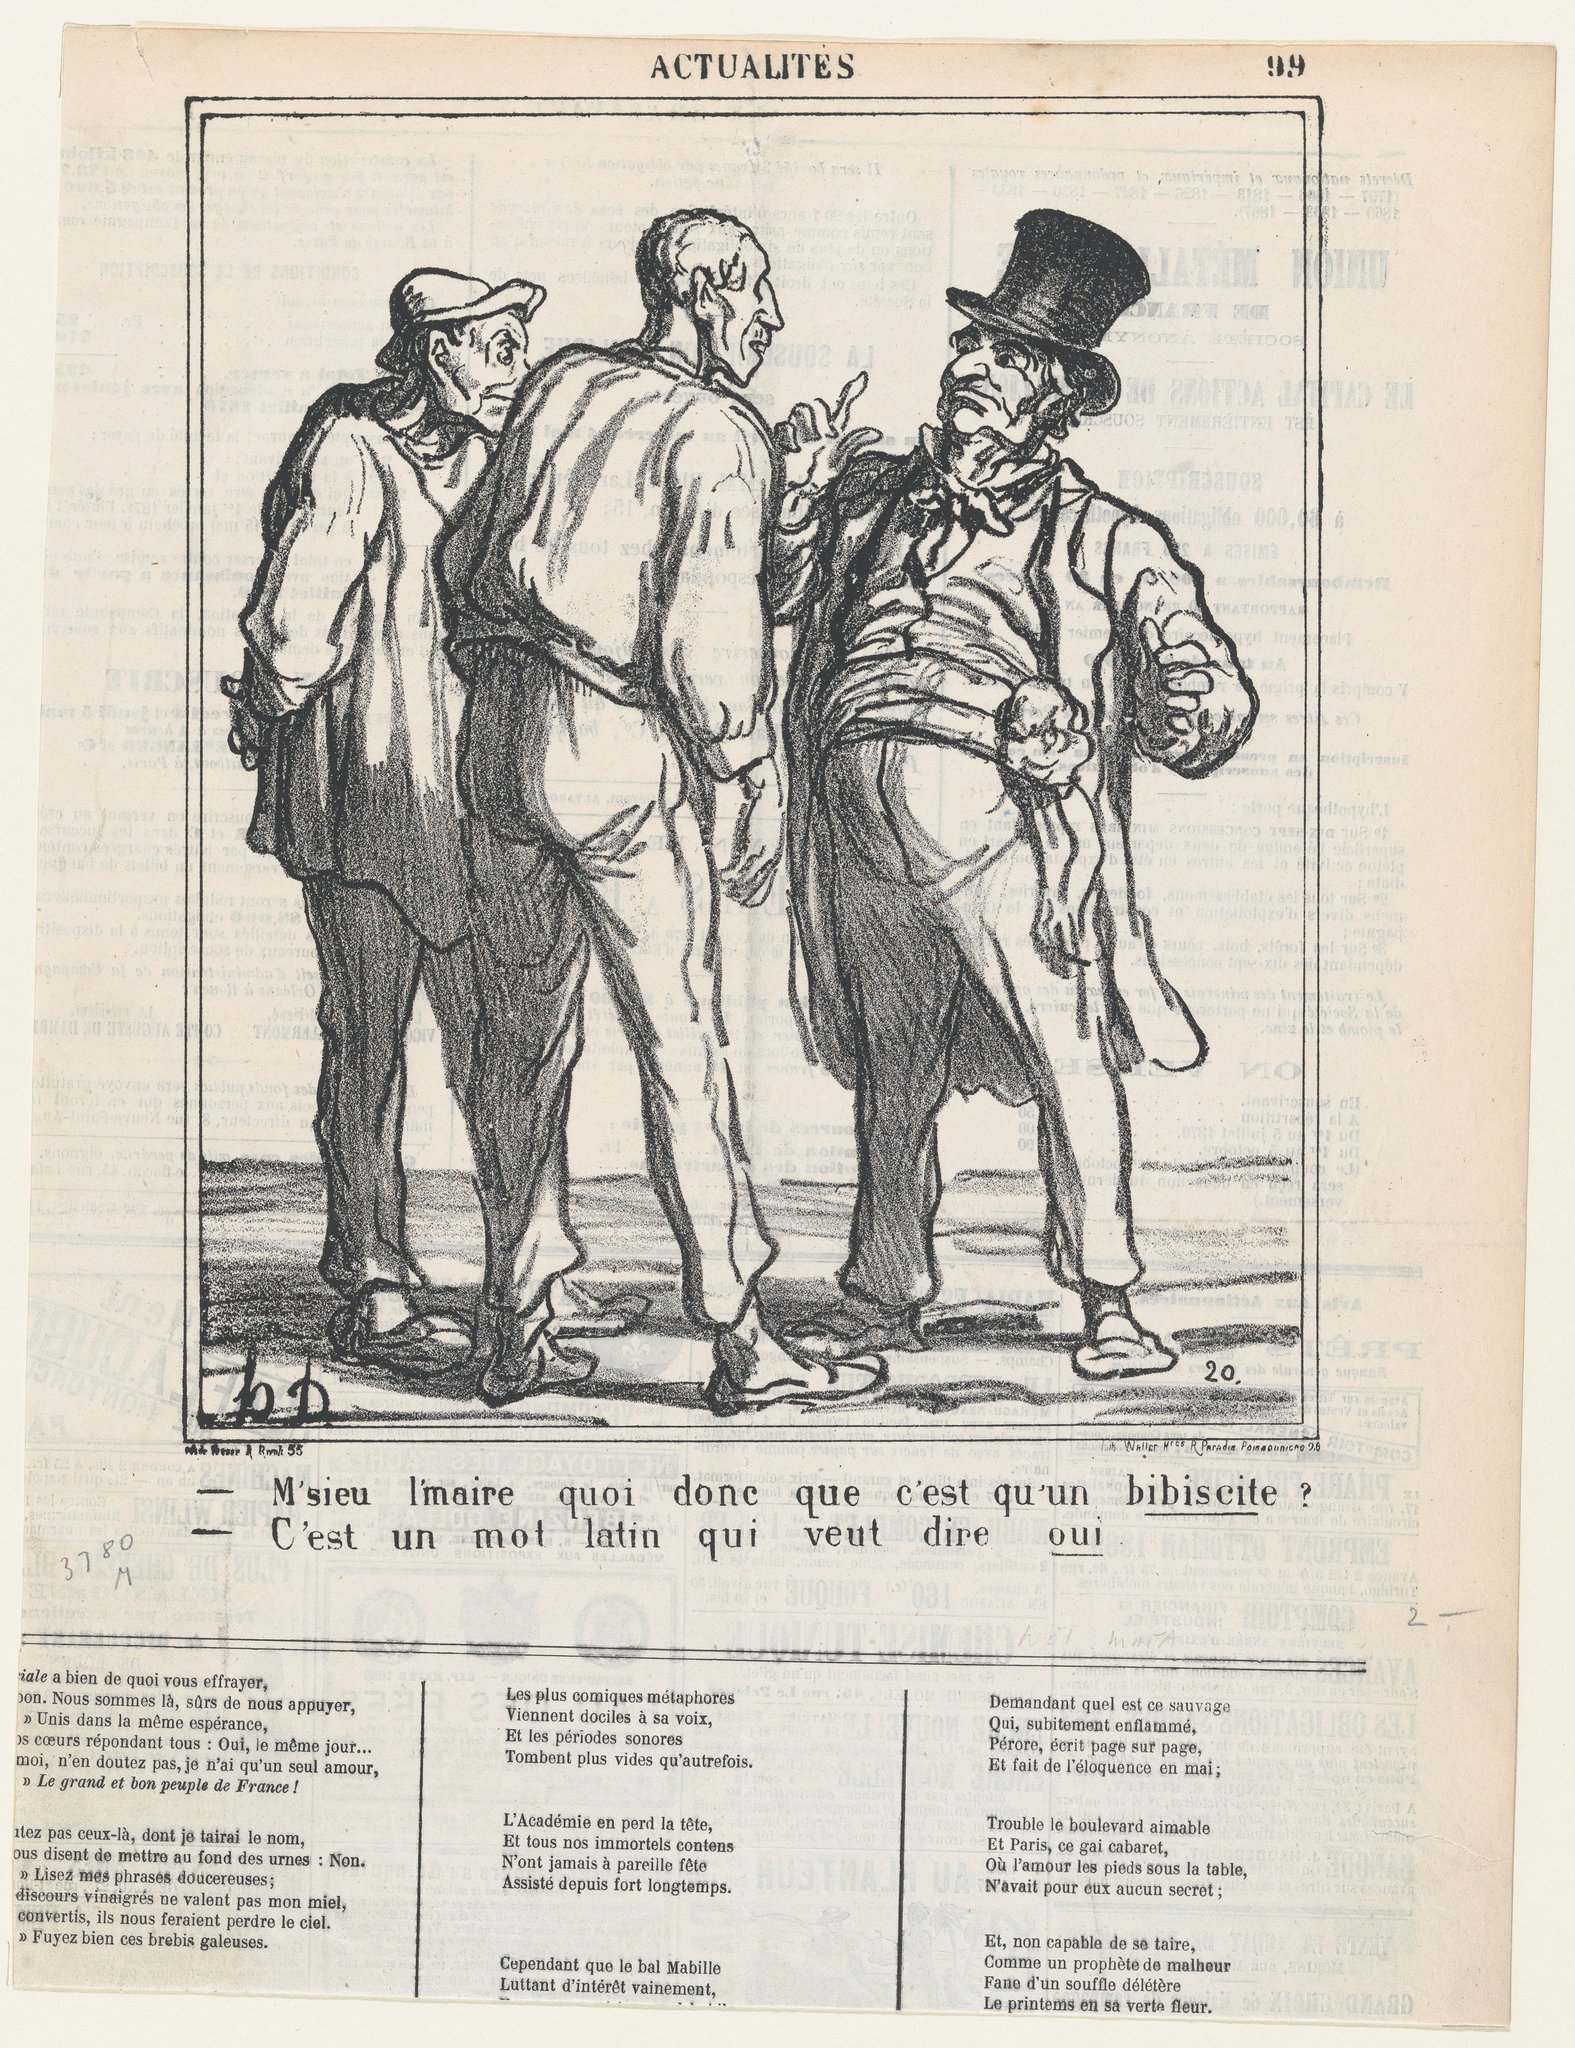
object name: print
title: –Mister Mayor, what is a bibiscite? –It is a Latin word that means yes, from 'News of the day,' published in Le Charivari, April 30, 1870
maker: honoré daumier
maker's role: artist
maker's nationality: french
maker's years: 1808-1879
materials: paper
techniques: lithograph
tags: satire,men